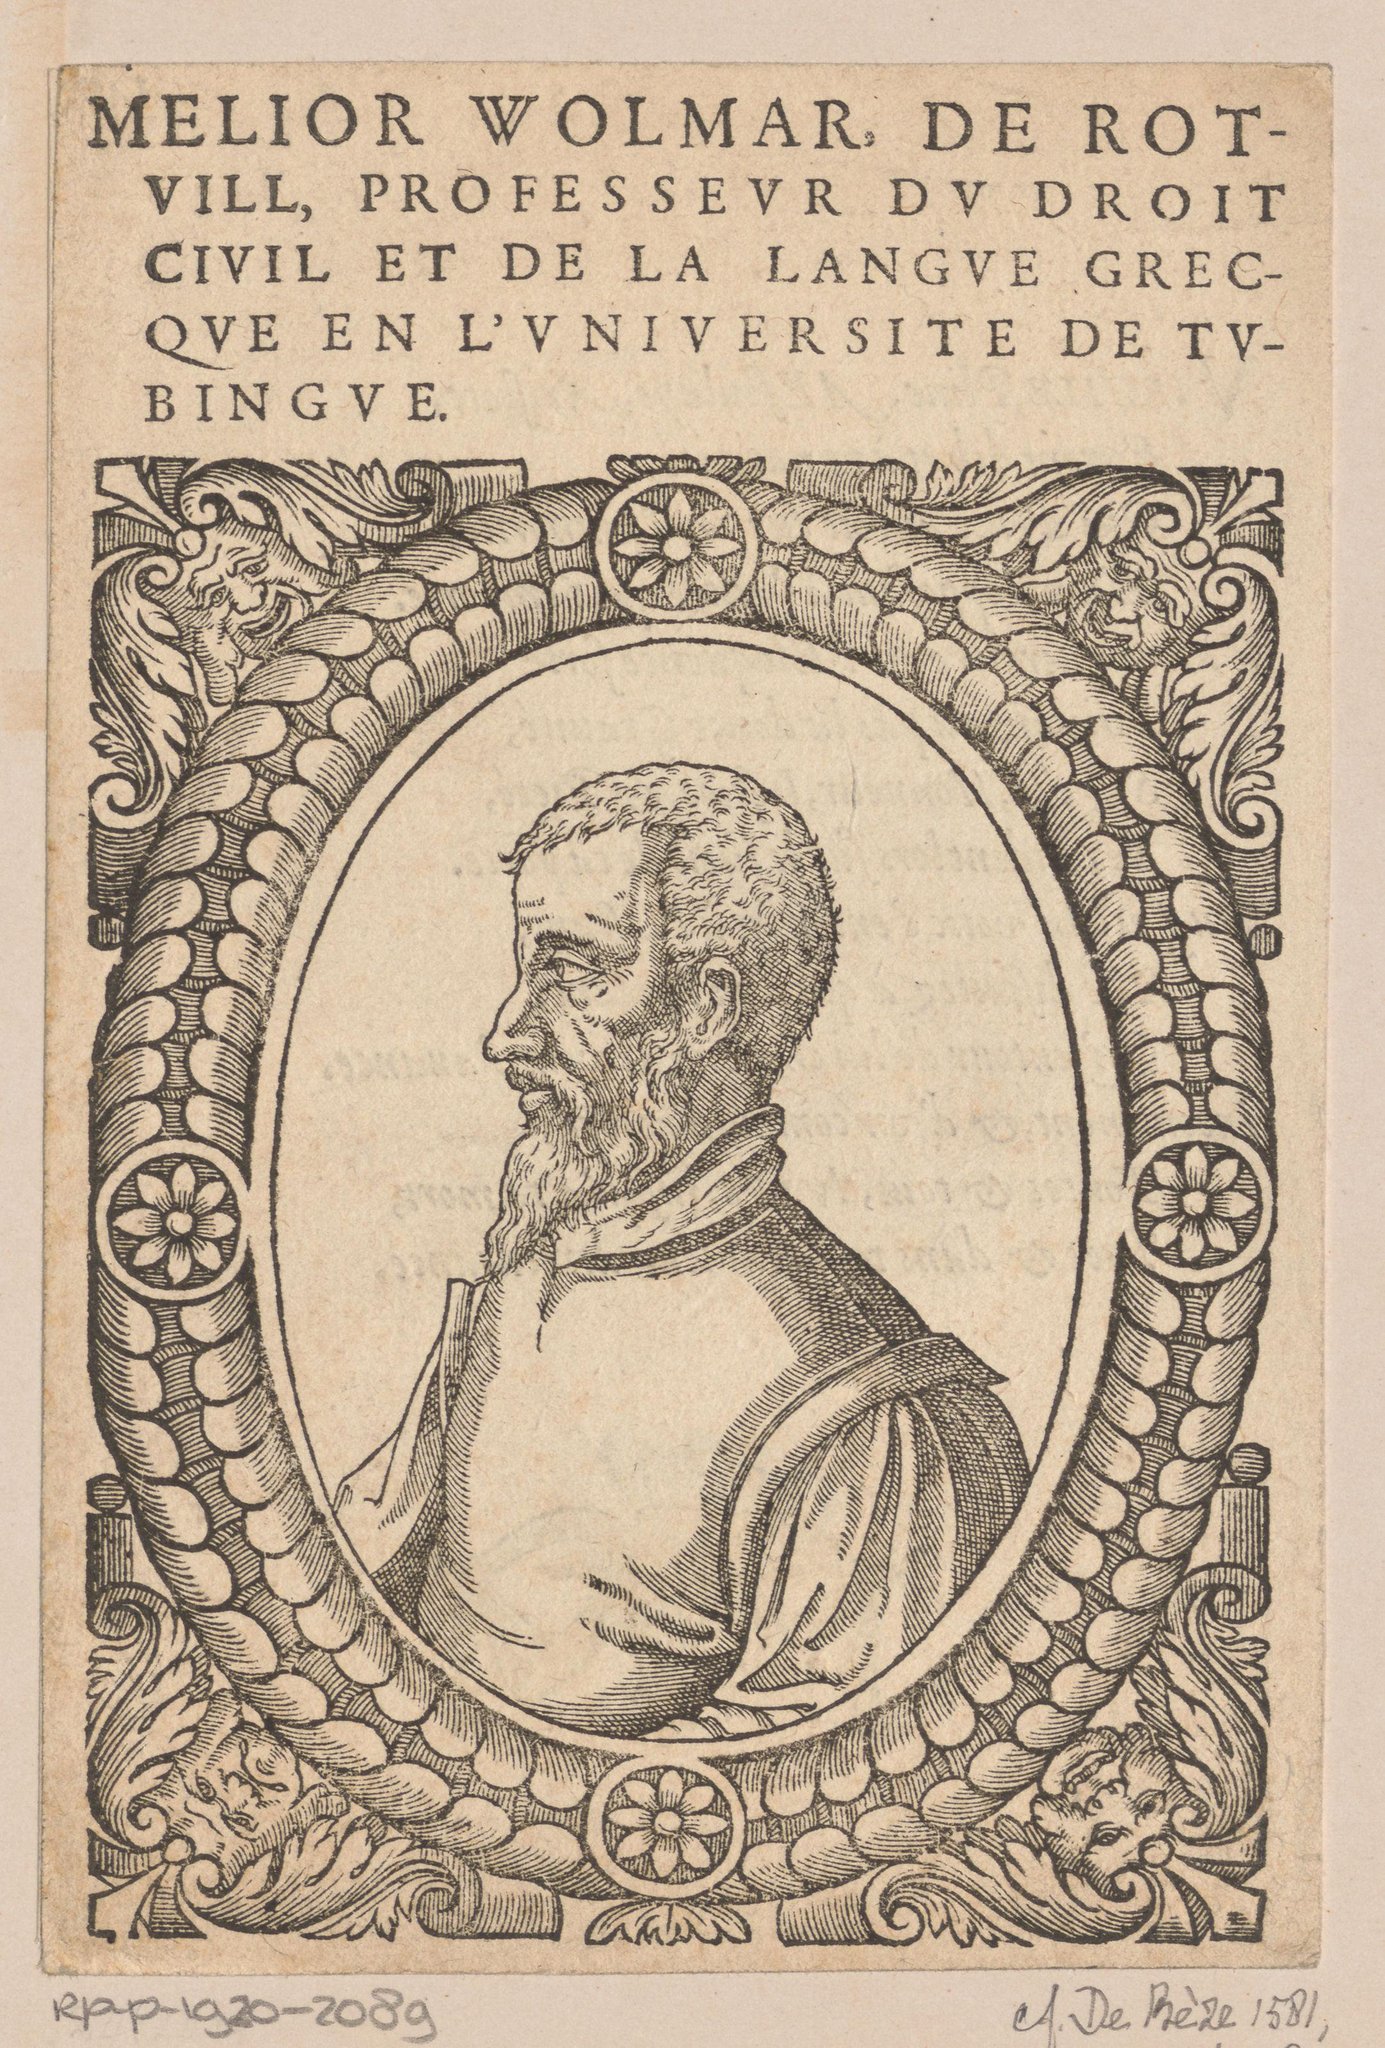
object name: book illustration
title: Portret van Melchior Rufus Volmar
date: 1580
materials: paper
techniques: letterpress printing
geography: geneva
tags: germany, scholar, philosopher, historical persons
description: Prent uit: Beze, Theodore de. Icones id est verae imagines virorum doctrina simul et pietate illustrium (...). Genève: Jean de Laon, 1580.